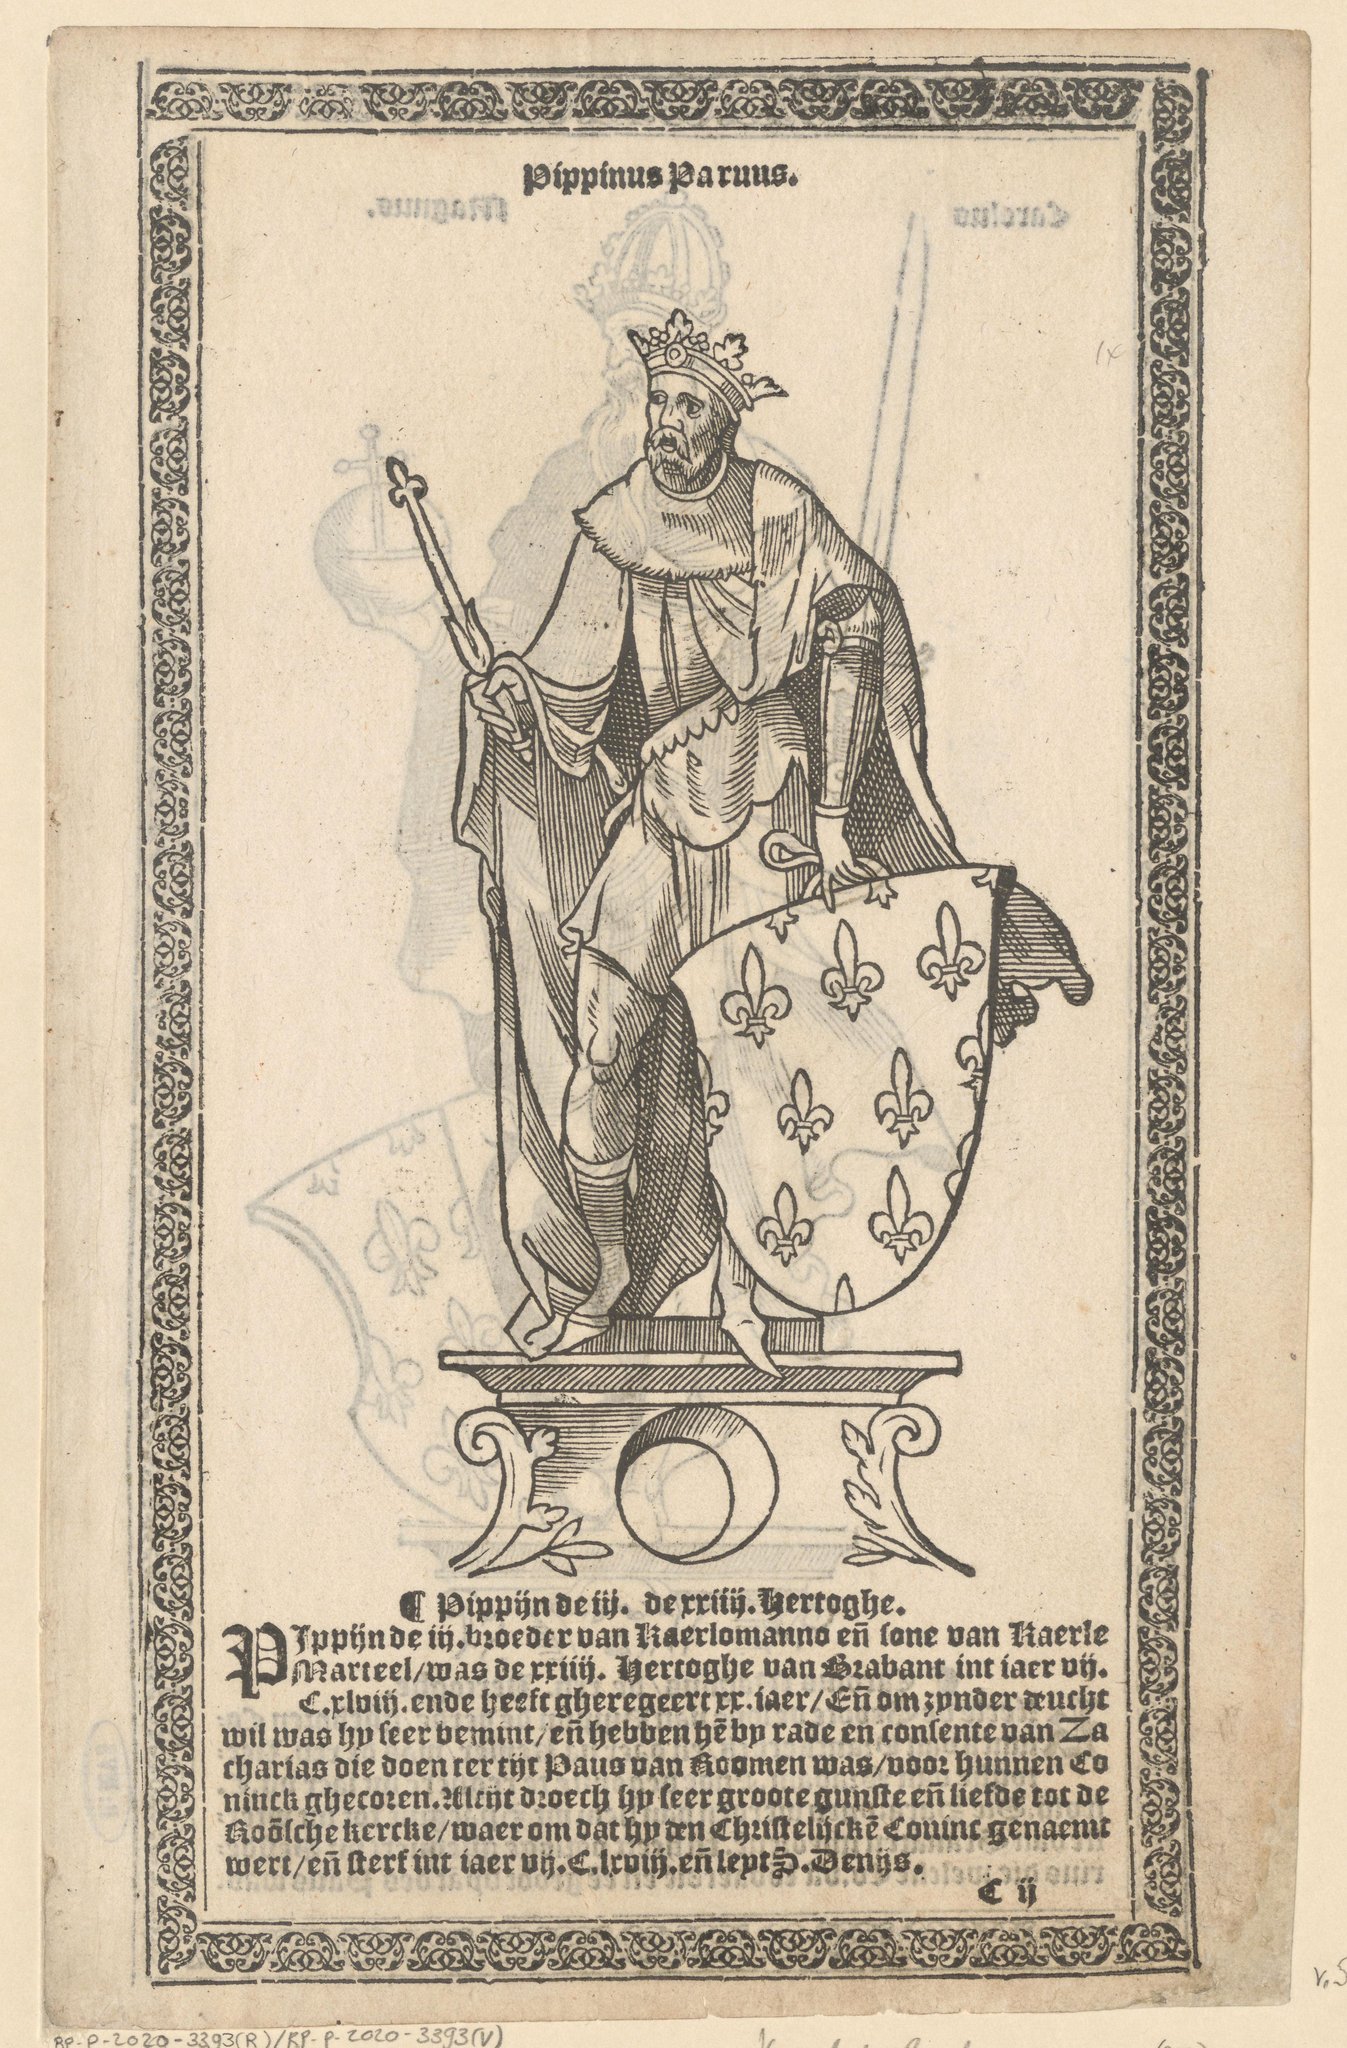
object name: print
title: Portret van Pepijn de Korte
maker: jan molijns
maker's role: print maker, publisher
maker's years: 1498-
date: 1565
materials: paper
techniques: letterpress printing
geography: antwerp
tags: liège, historical persons, king, armorial bearing, heraldry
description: Prent uit: Dit is die afcoemste ende genalogie der hertoghen ende hertoginnen van Brabandt, (...). Antwerpen: Jan Molijns, 1565.